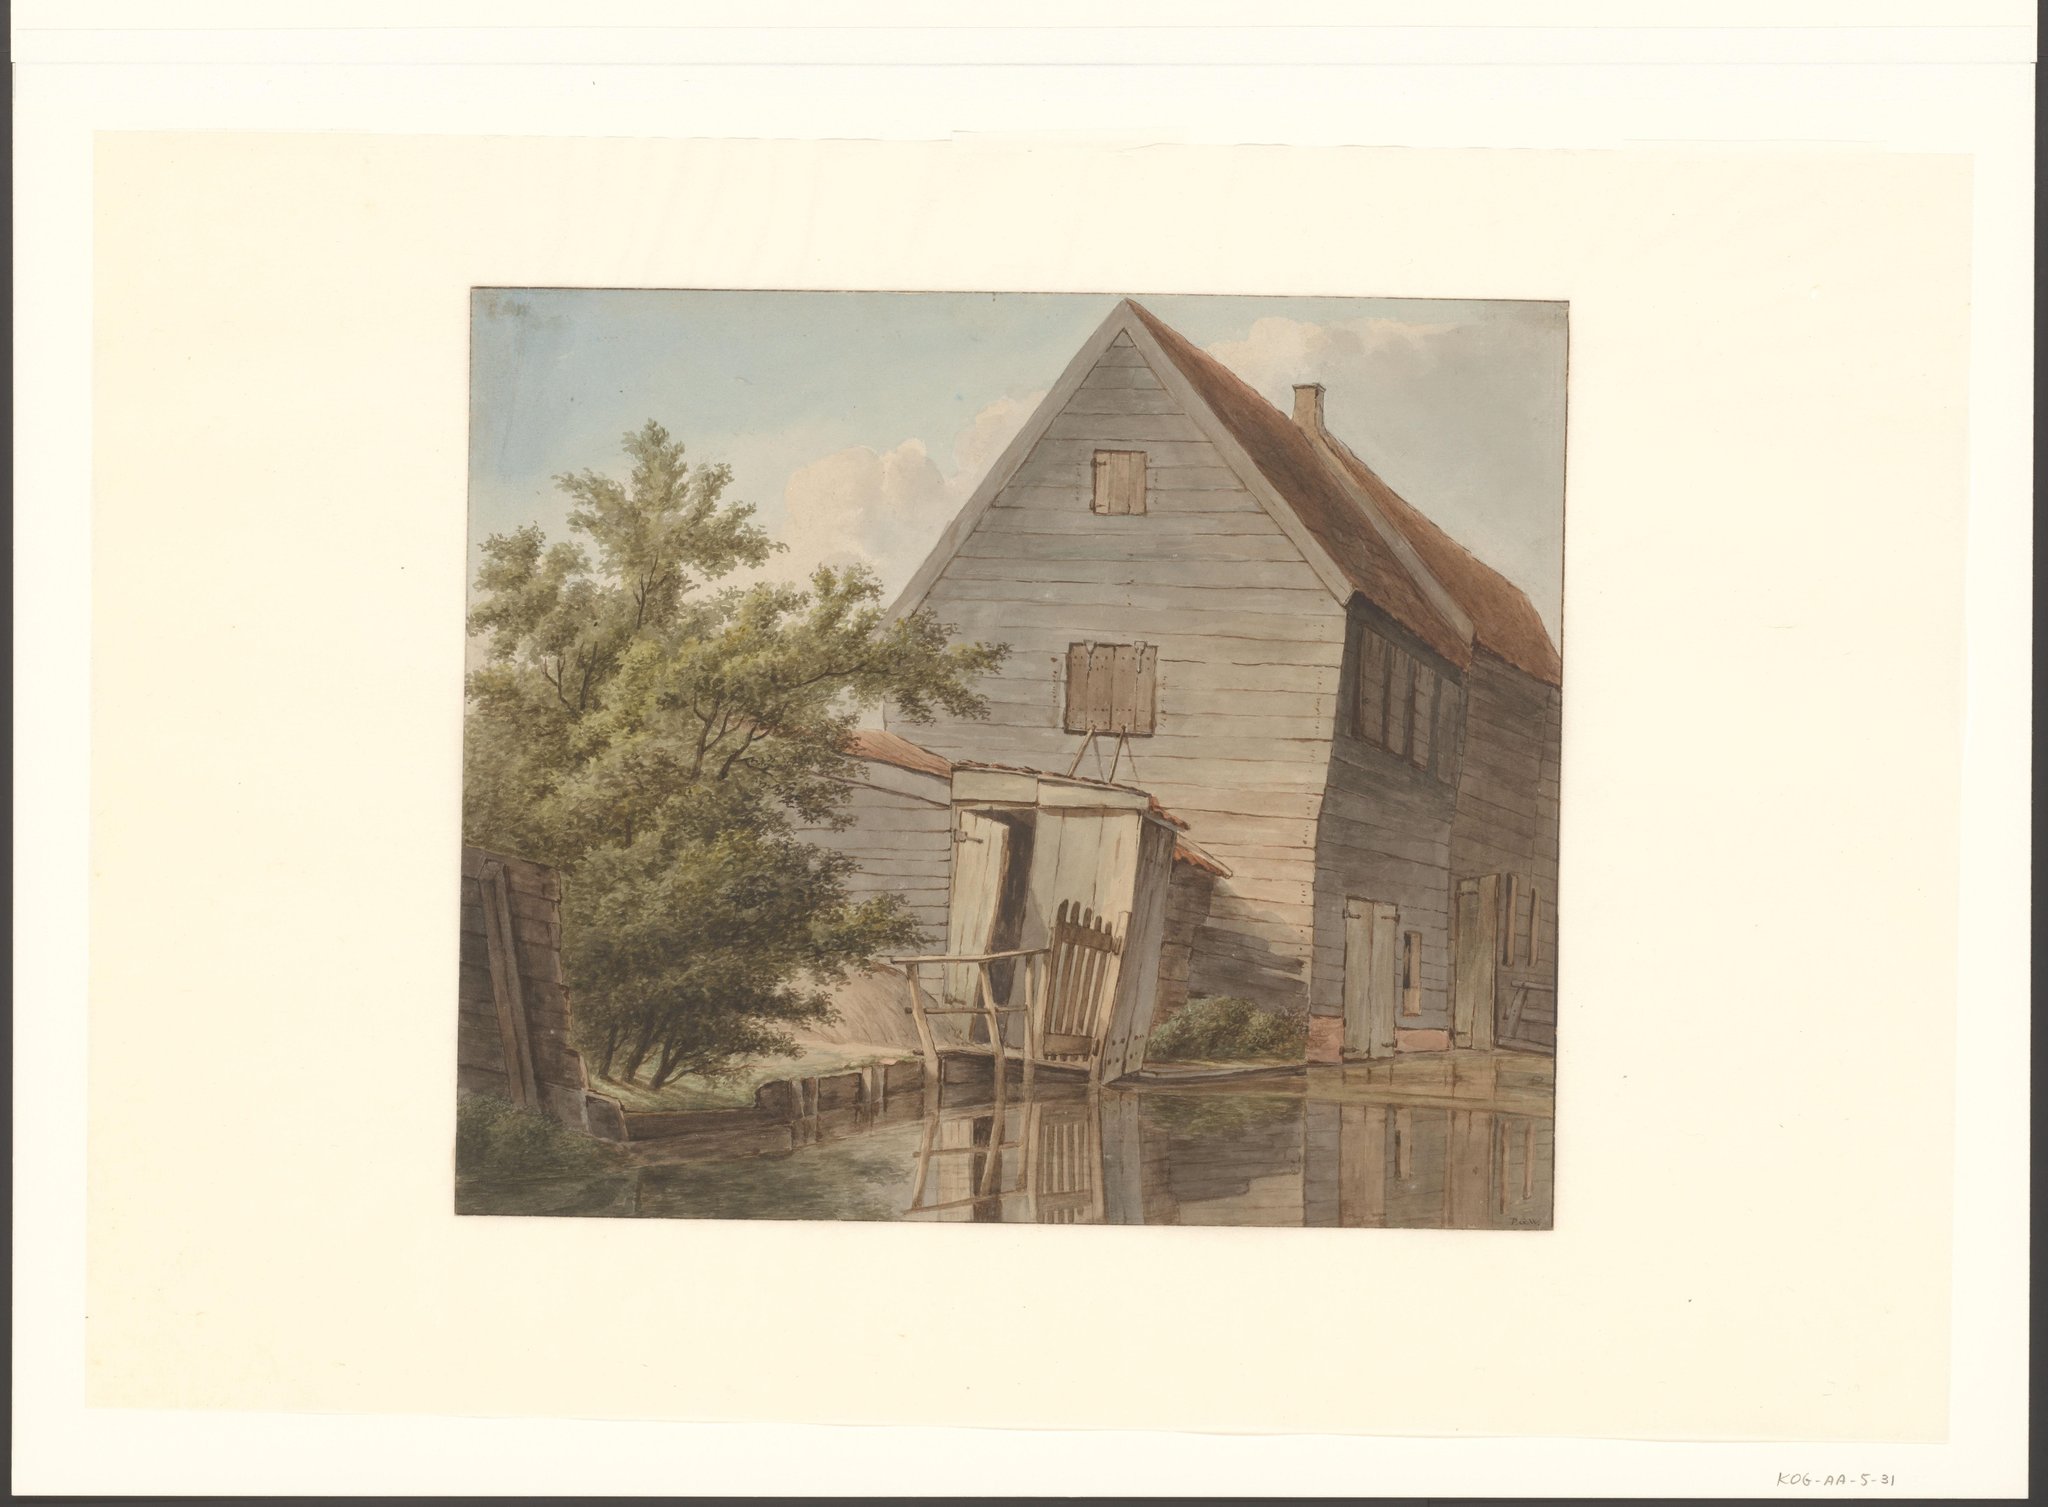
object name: drawing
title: Gezicht op een loods langs de Baangracht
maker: george pieter westenberg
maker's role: draughtsman, painter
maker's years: 1791-1873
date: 1801-1873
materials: gouache, ink, paper, pencil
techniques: brush, pen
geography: amsterdam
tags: city-view in general; 'veduta', canal, shed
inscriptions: signature: ‘P.G.W.’, number: ‘21’, inscription: ‘op de Baangracht / te Amsterdam’